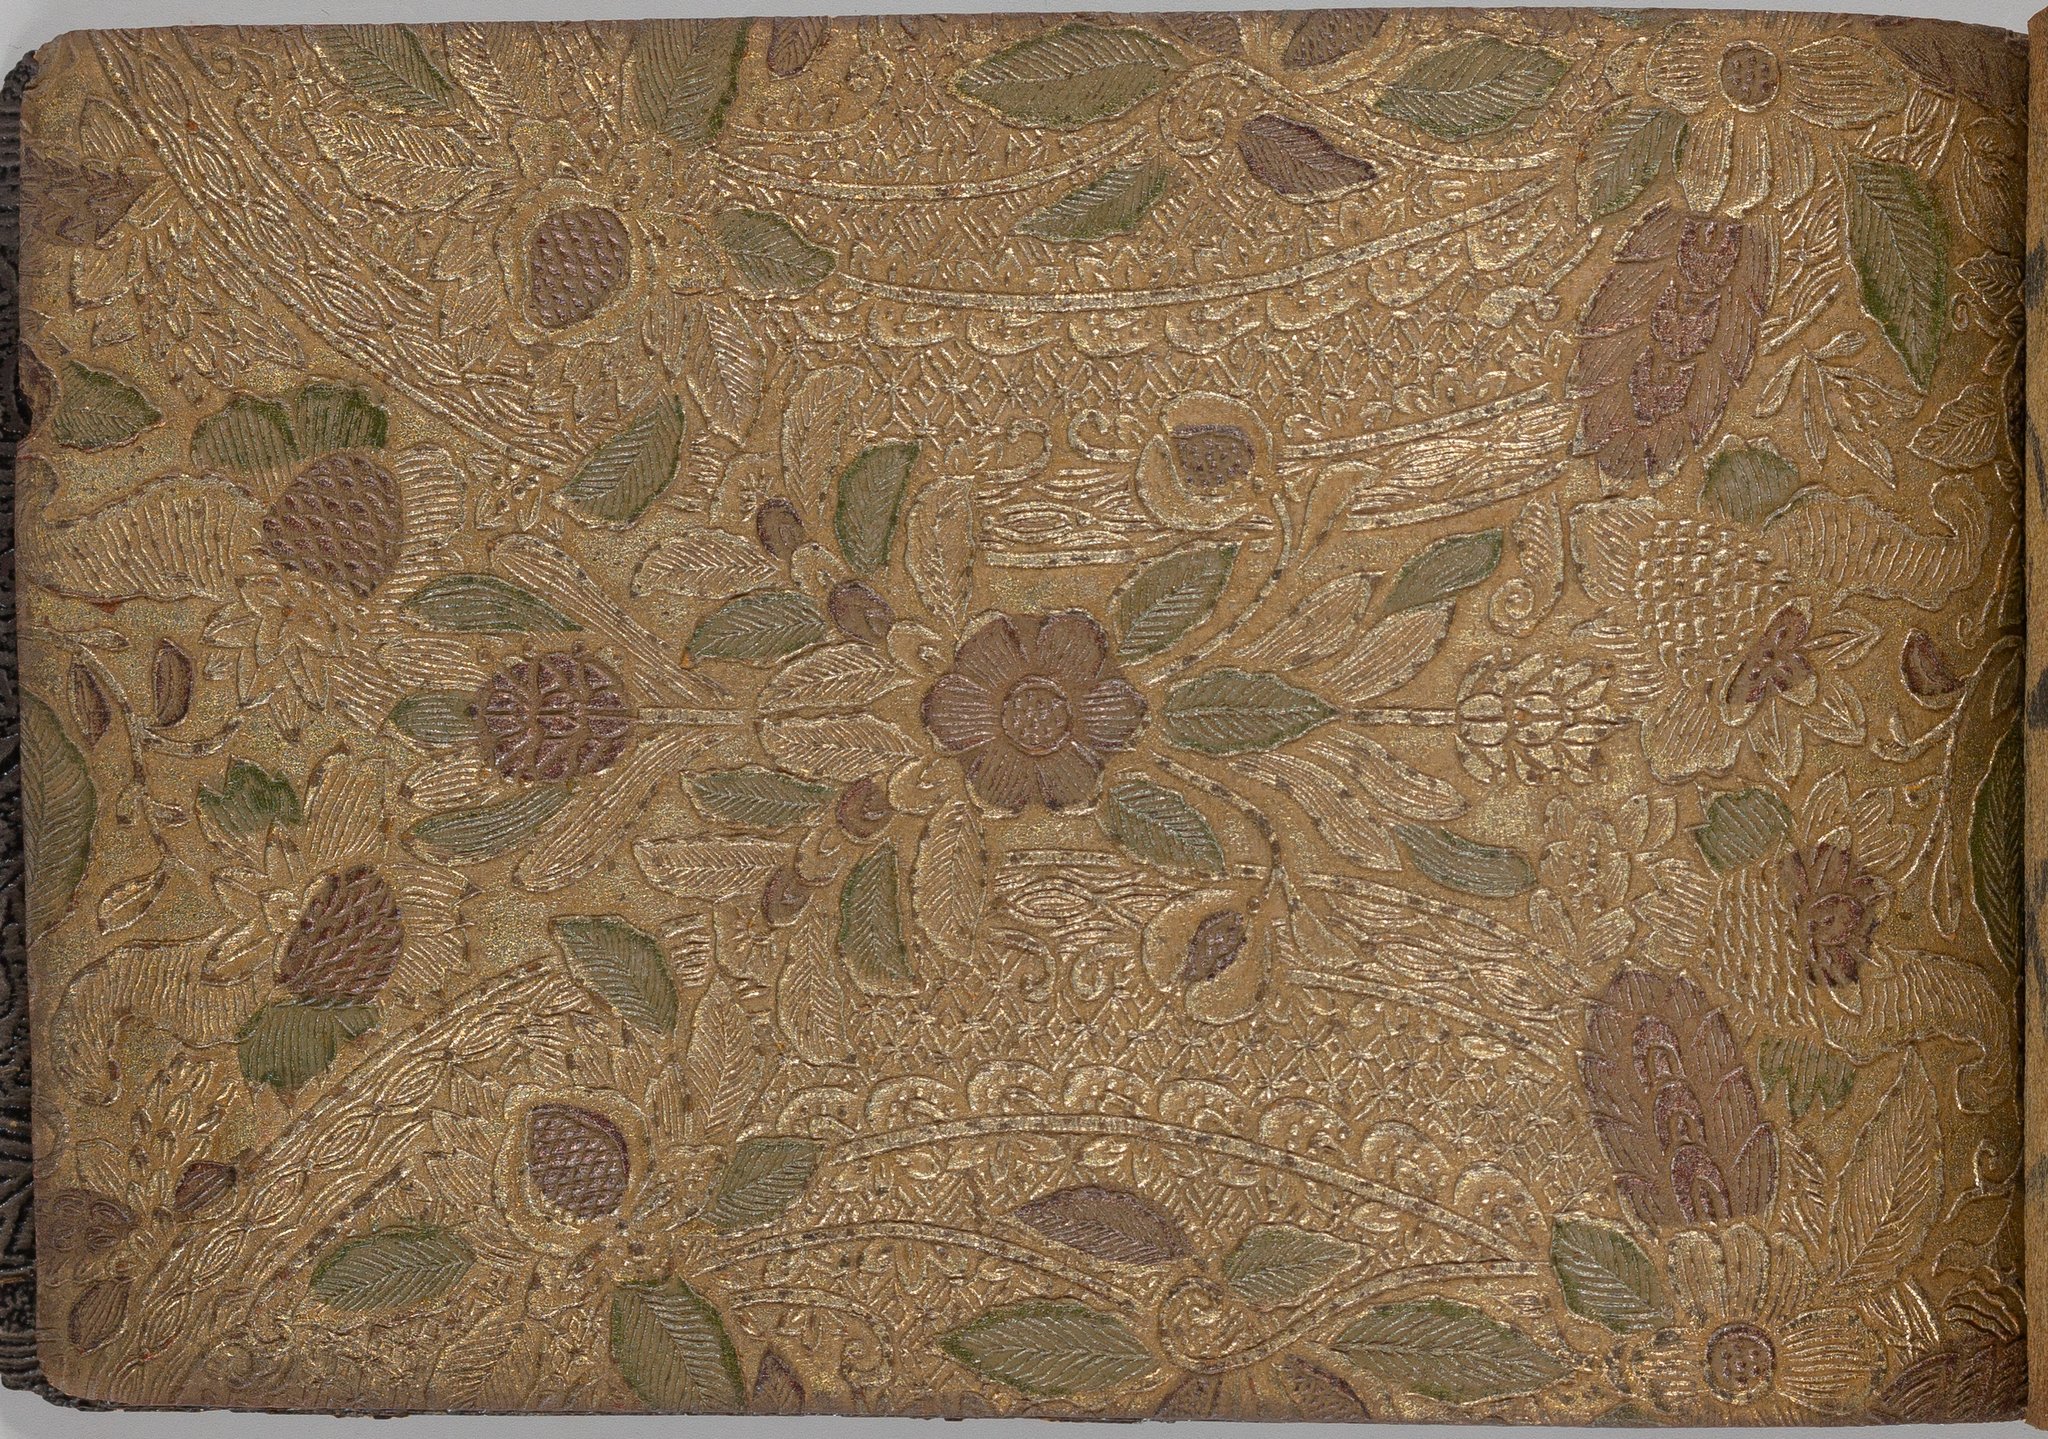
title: 大高檀紙见本帖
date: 1875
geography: japan